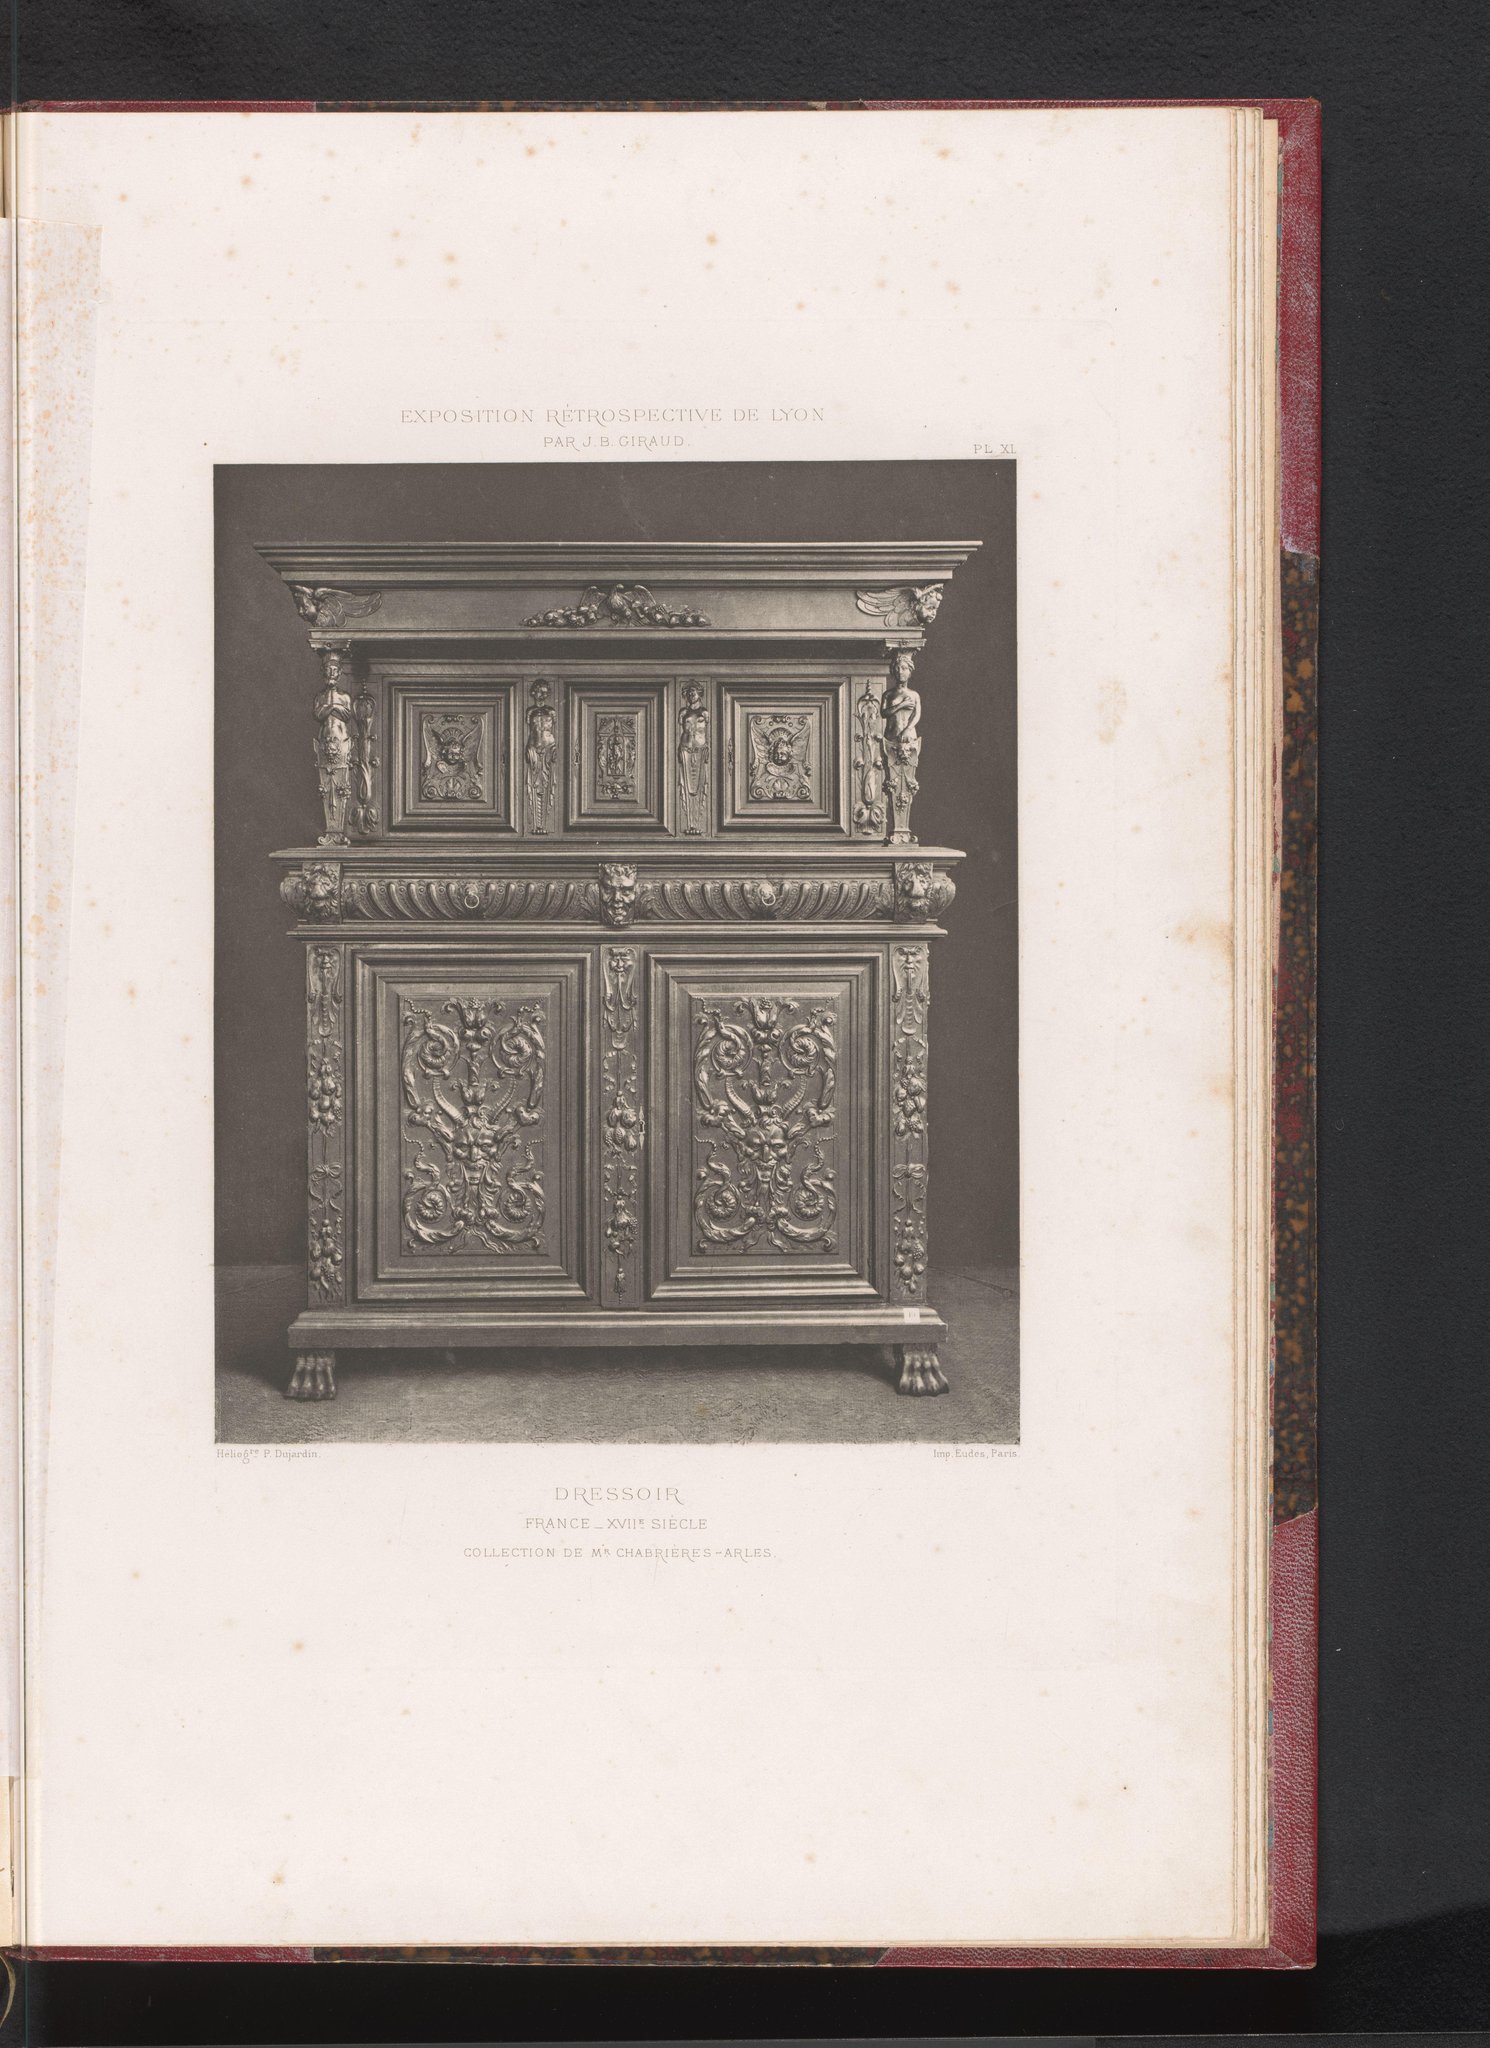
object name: page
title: 17de-eeuws Frans dressoir van hout, op de Exposition Rétrospective van 1877 in Lyon, Frankrijk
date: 1877-1880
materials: paper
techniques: photoaquatint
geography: lyon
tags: ornamental cupboard (+ wood and other phytogenic material), lyon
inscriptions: inscription: ‘EXPOSITION RÉTROSPECTIVE DE LYON/ PAR J. B. GIRAUD.’, inscription: ‘DRESSOIR/ FRANCE_XVIIe SIÈCLE/ COLLECTION DE Mr CHAMBRIÈRES-ARLES.’, number: ‘PL. XL.’